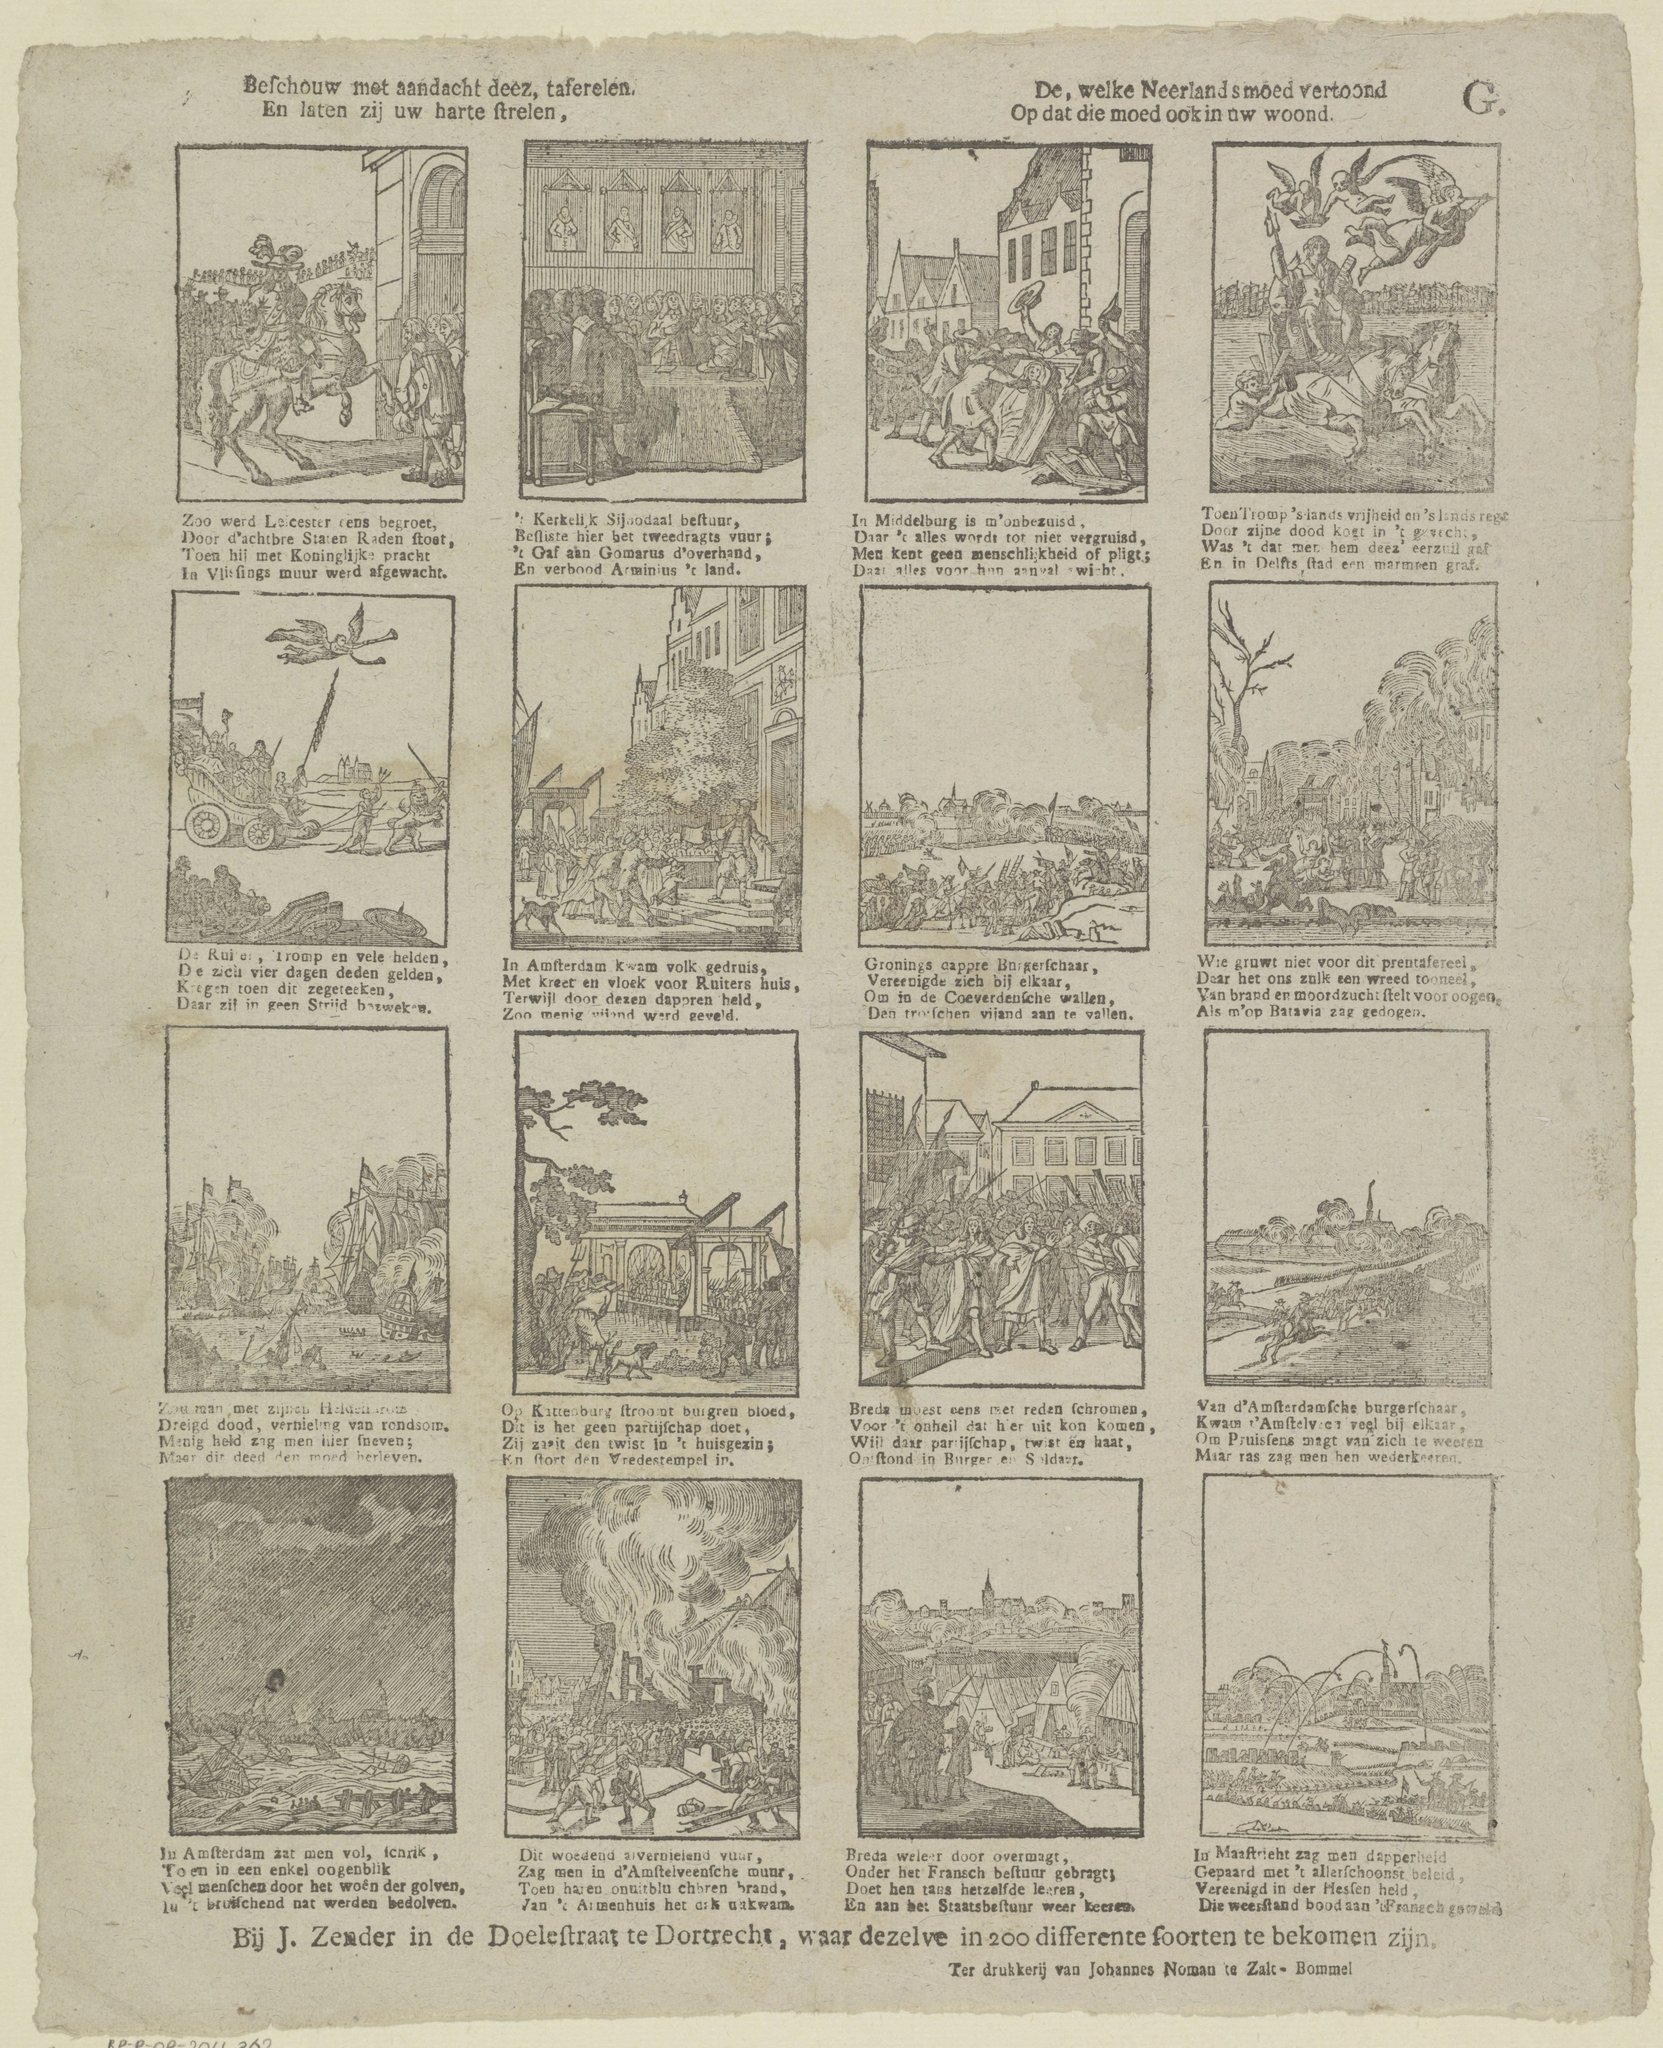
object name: popular print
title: Beschouw met aandacht deez' tafreelen, / En laten zij uw harte streelen, / Die, welke Neerlands moed vertoond, / Op dat die moed ook in uw woond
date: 1806-1830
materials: paper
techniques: letterpress printing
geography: netherlands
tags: flushing, michiel adriaenszoon de ruyter, rotterdam, cornelis tromp, bruges, robert dudley (1st earl of leicester), history, delft, middelburg, amsterdam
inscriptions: collector's mark: Lugt 2760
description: Blad met 16 voorstellingen van gebeurtenissen uit de vaderlandse geschiedenis, zoals het ontzet van Coevorden in 1594 en het ontzet en de inname van Breda in 1637. Onder elke afbeelding een vierregelig vers. Gemerkt rechtsboven: G.